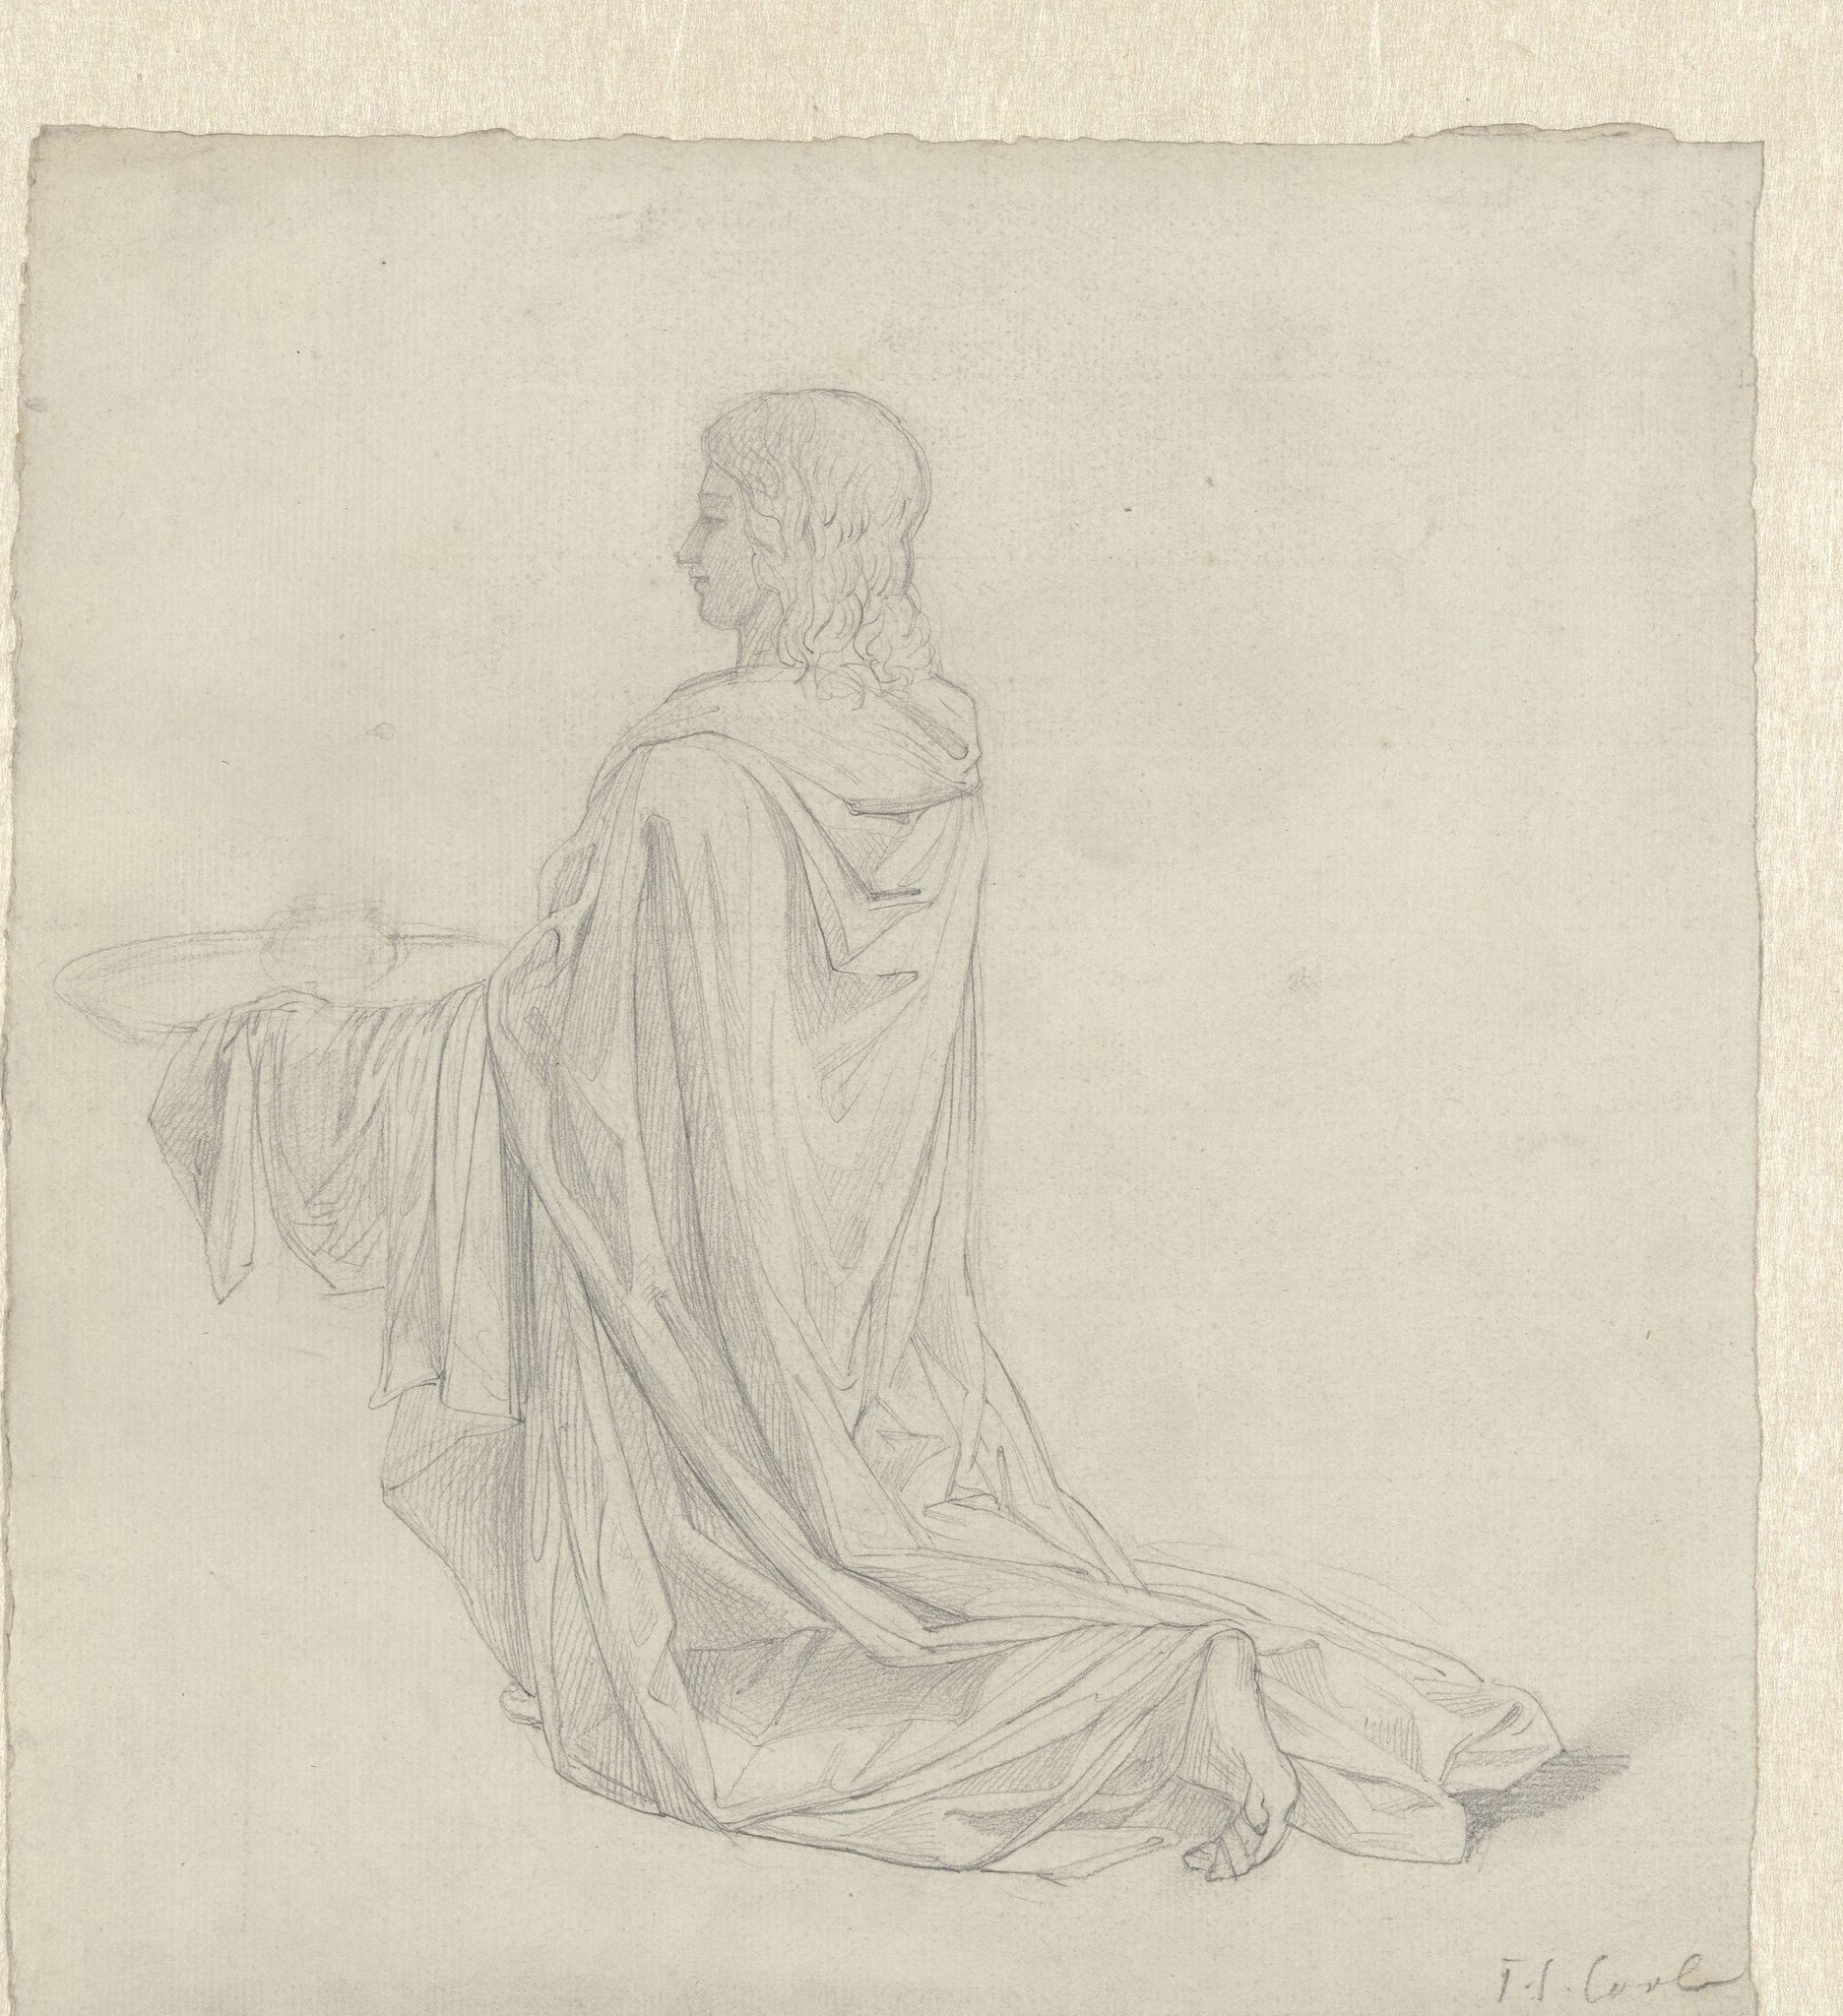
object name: drawing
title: Geknielde jongen in wijde mantel met een schaal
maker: thomas simon cool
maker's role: draughtsman, print maker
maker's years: 1831-1870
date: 1841-1871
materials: paper, pencil